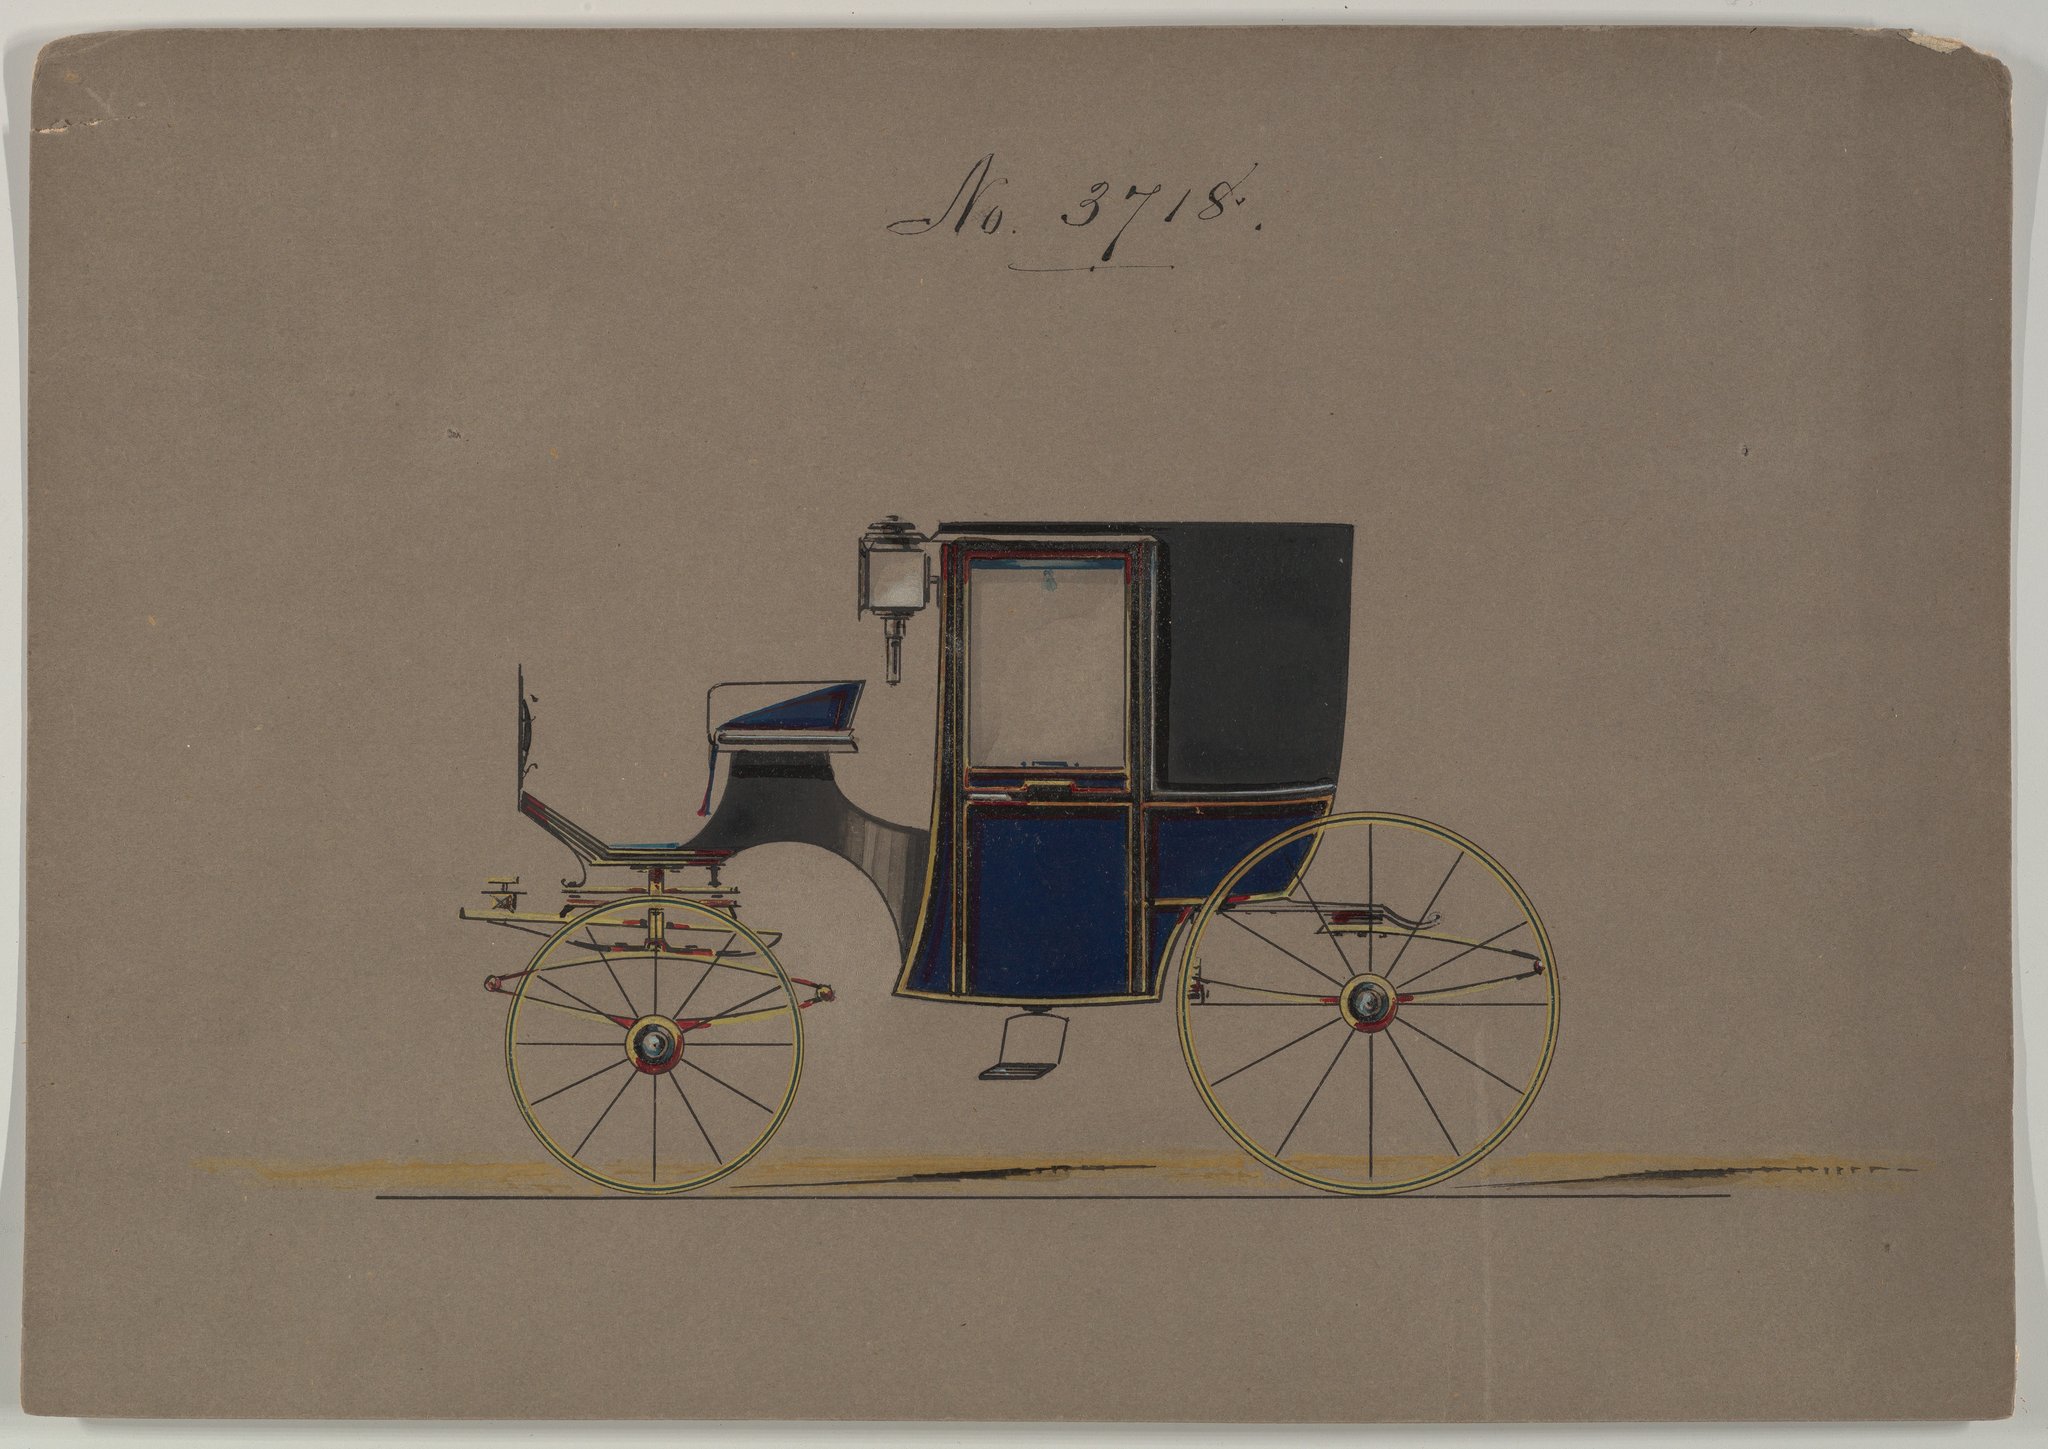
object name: drawing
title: Brougham #3718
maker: brewster & co.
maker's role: manufacturer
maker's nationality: american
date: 1881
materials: gouache, gum arabic, ink, watercolor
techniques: pen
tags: carriages